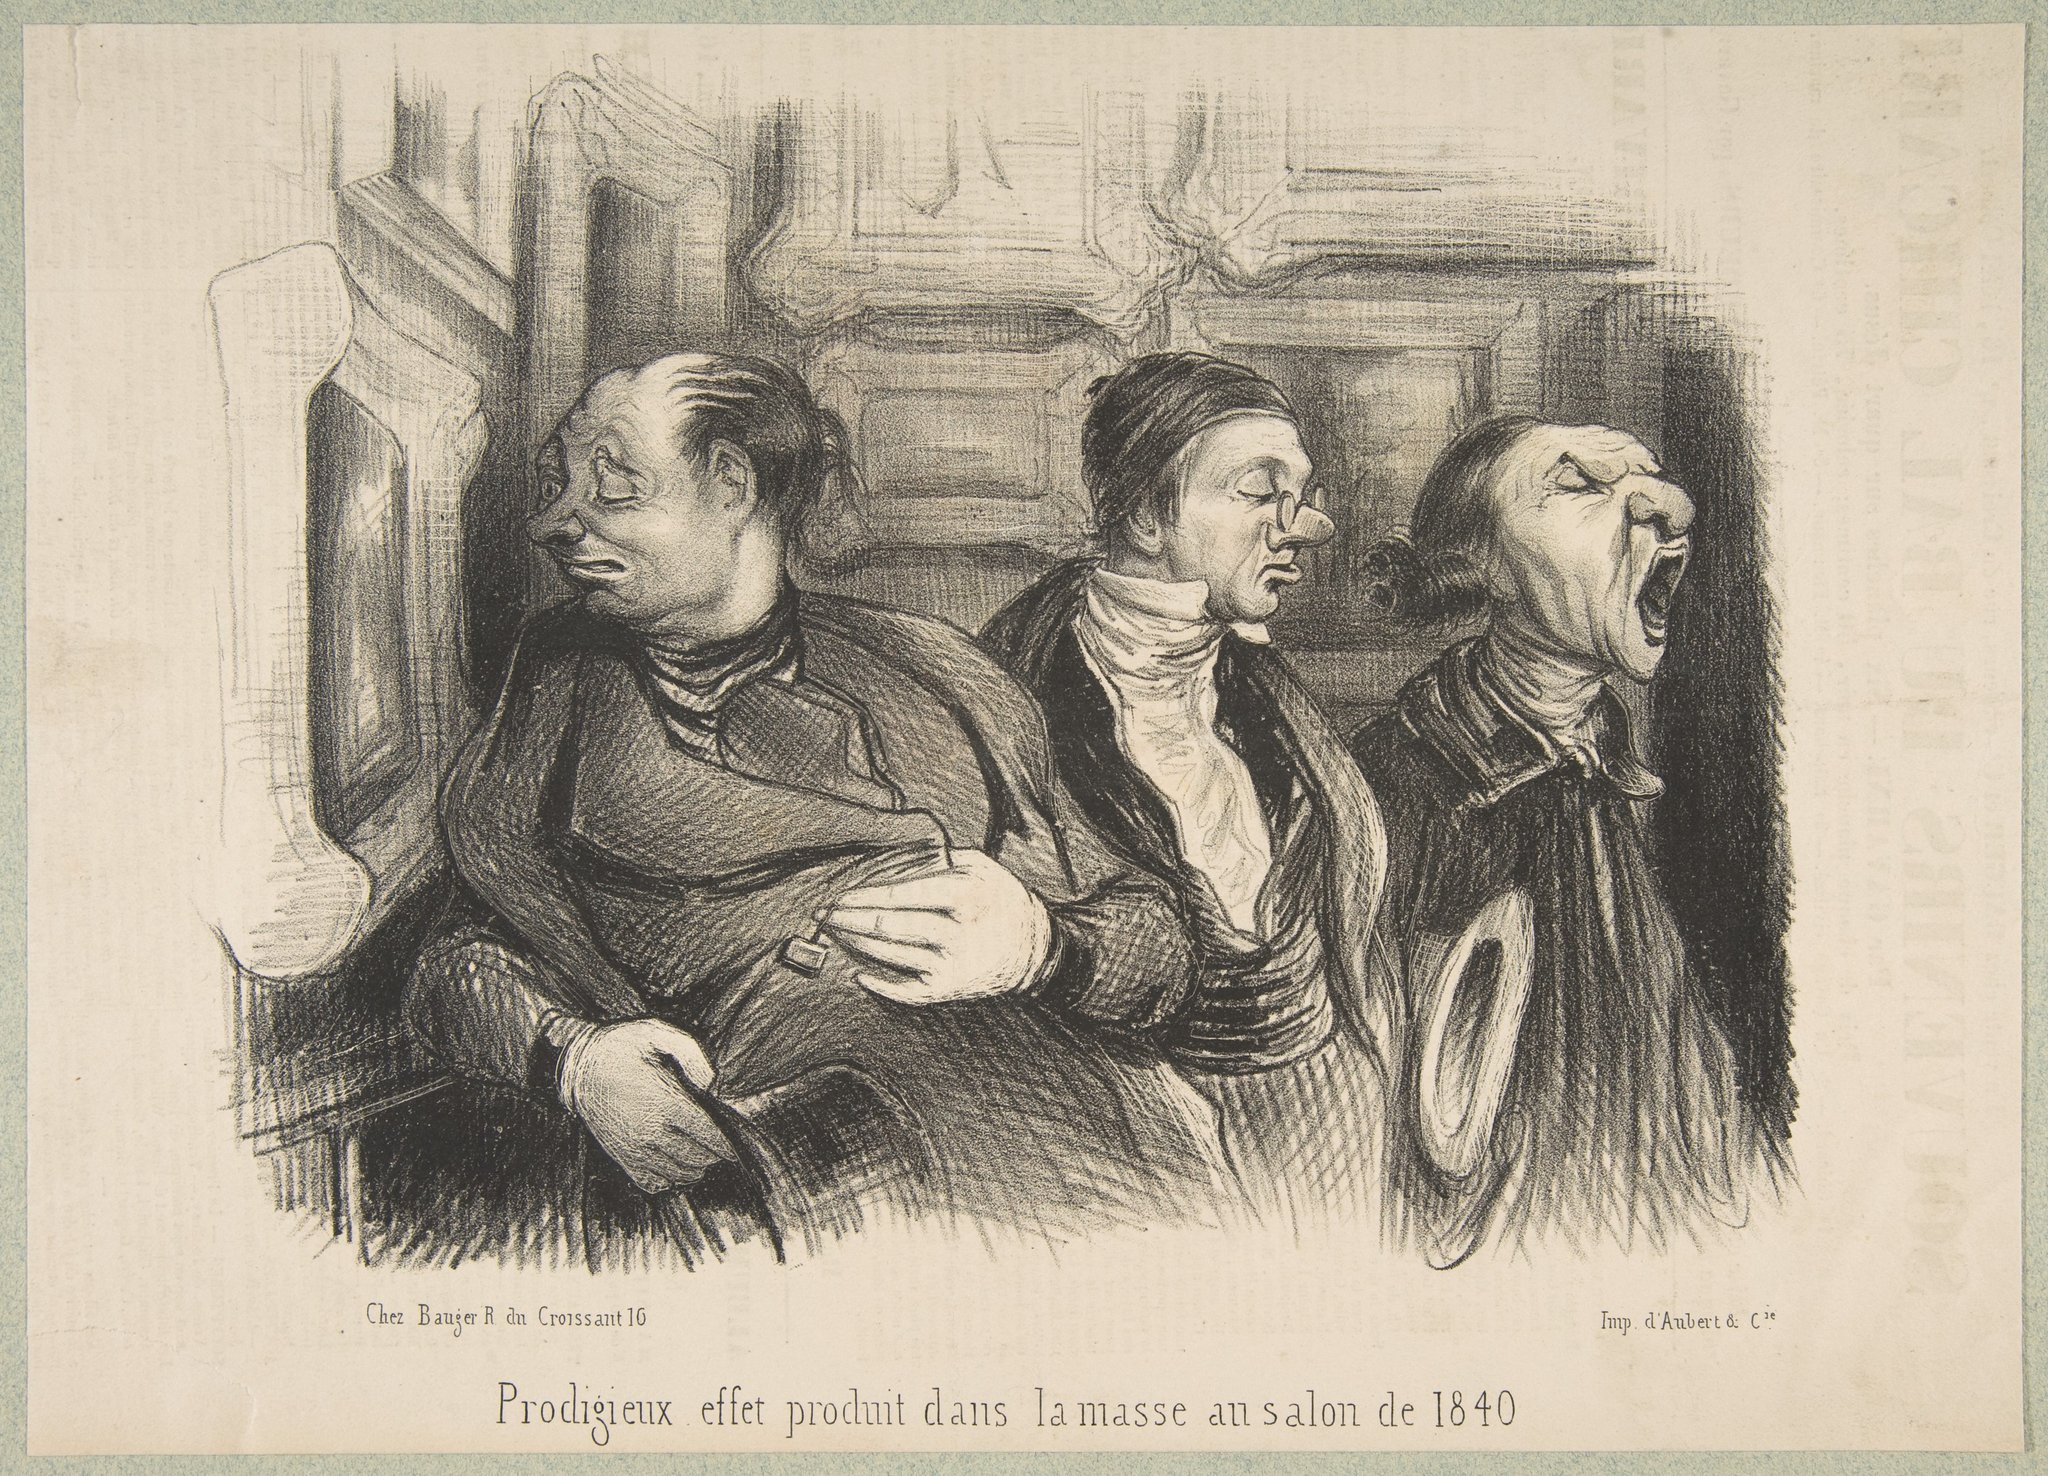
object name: print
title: Prodigieux Effet Produit dans la Masse au Salon de 1840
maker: anonymous, french, 19th century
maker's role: artist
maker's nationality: french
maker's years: 1800-1900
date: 1840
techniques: lithograph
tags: men